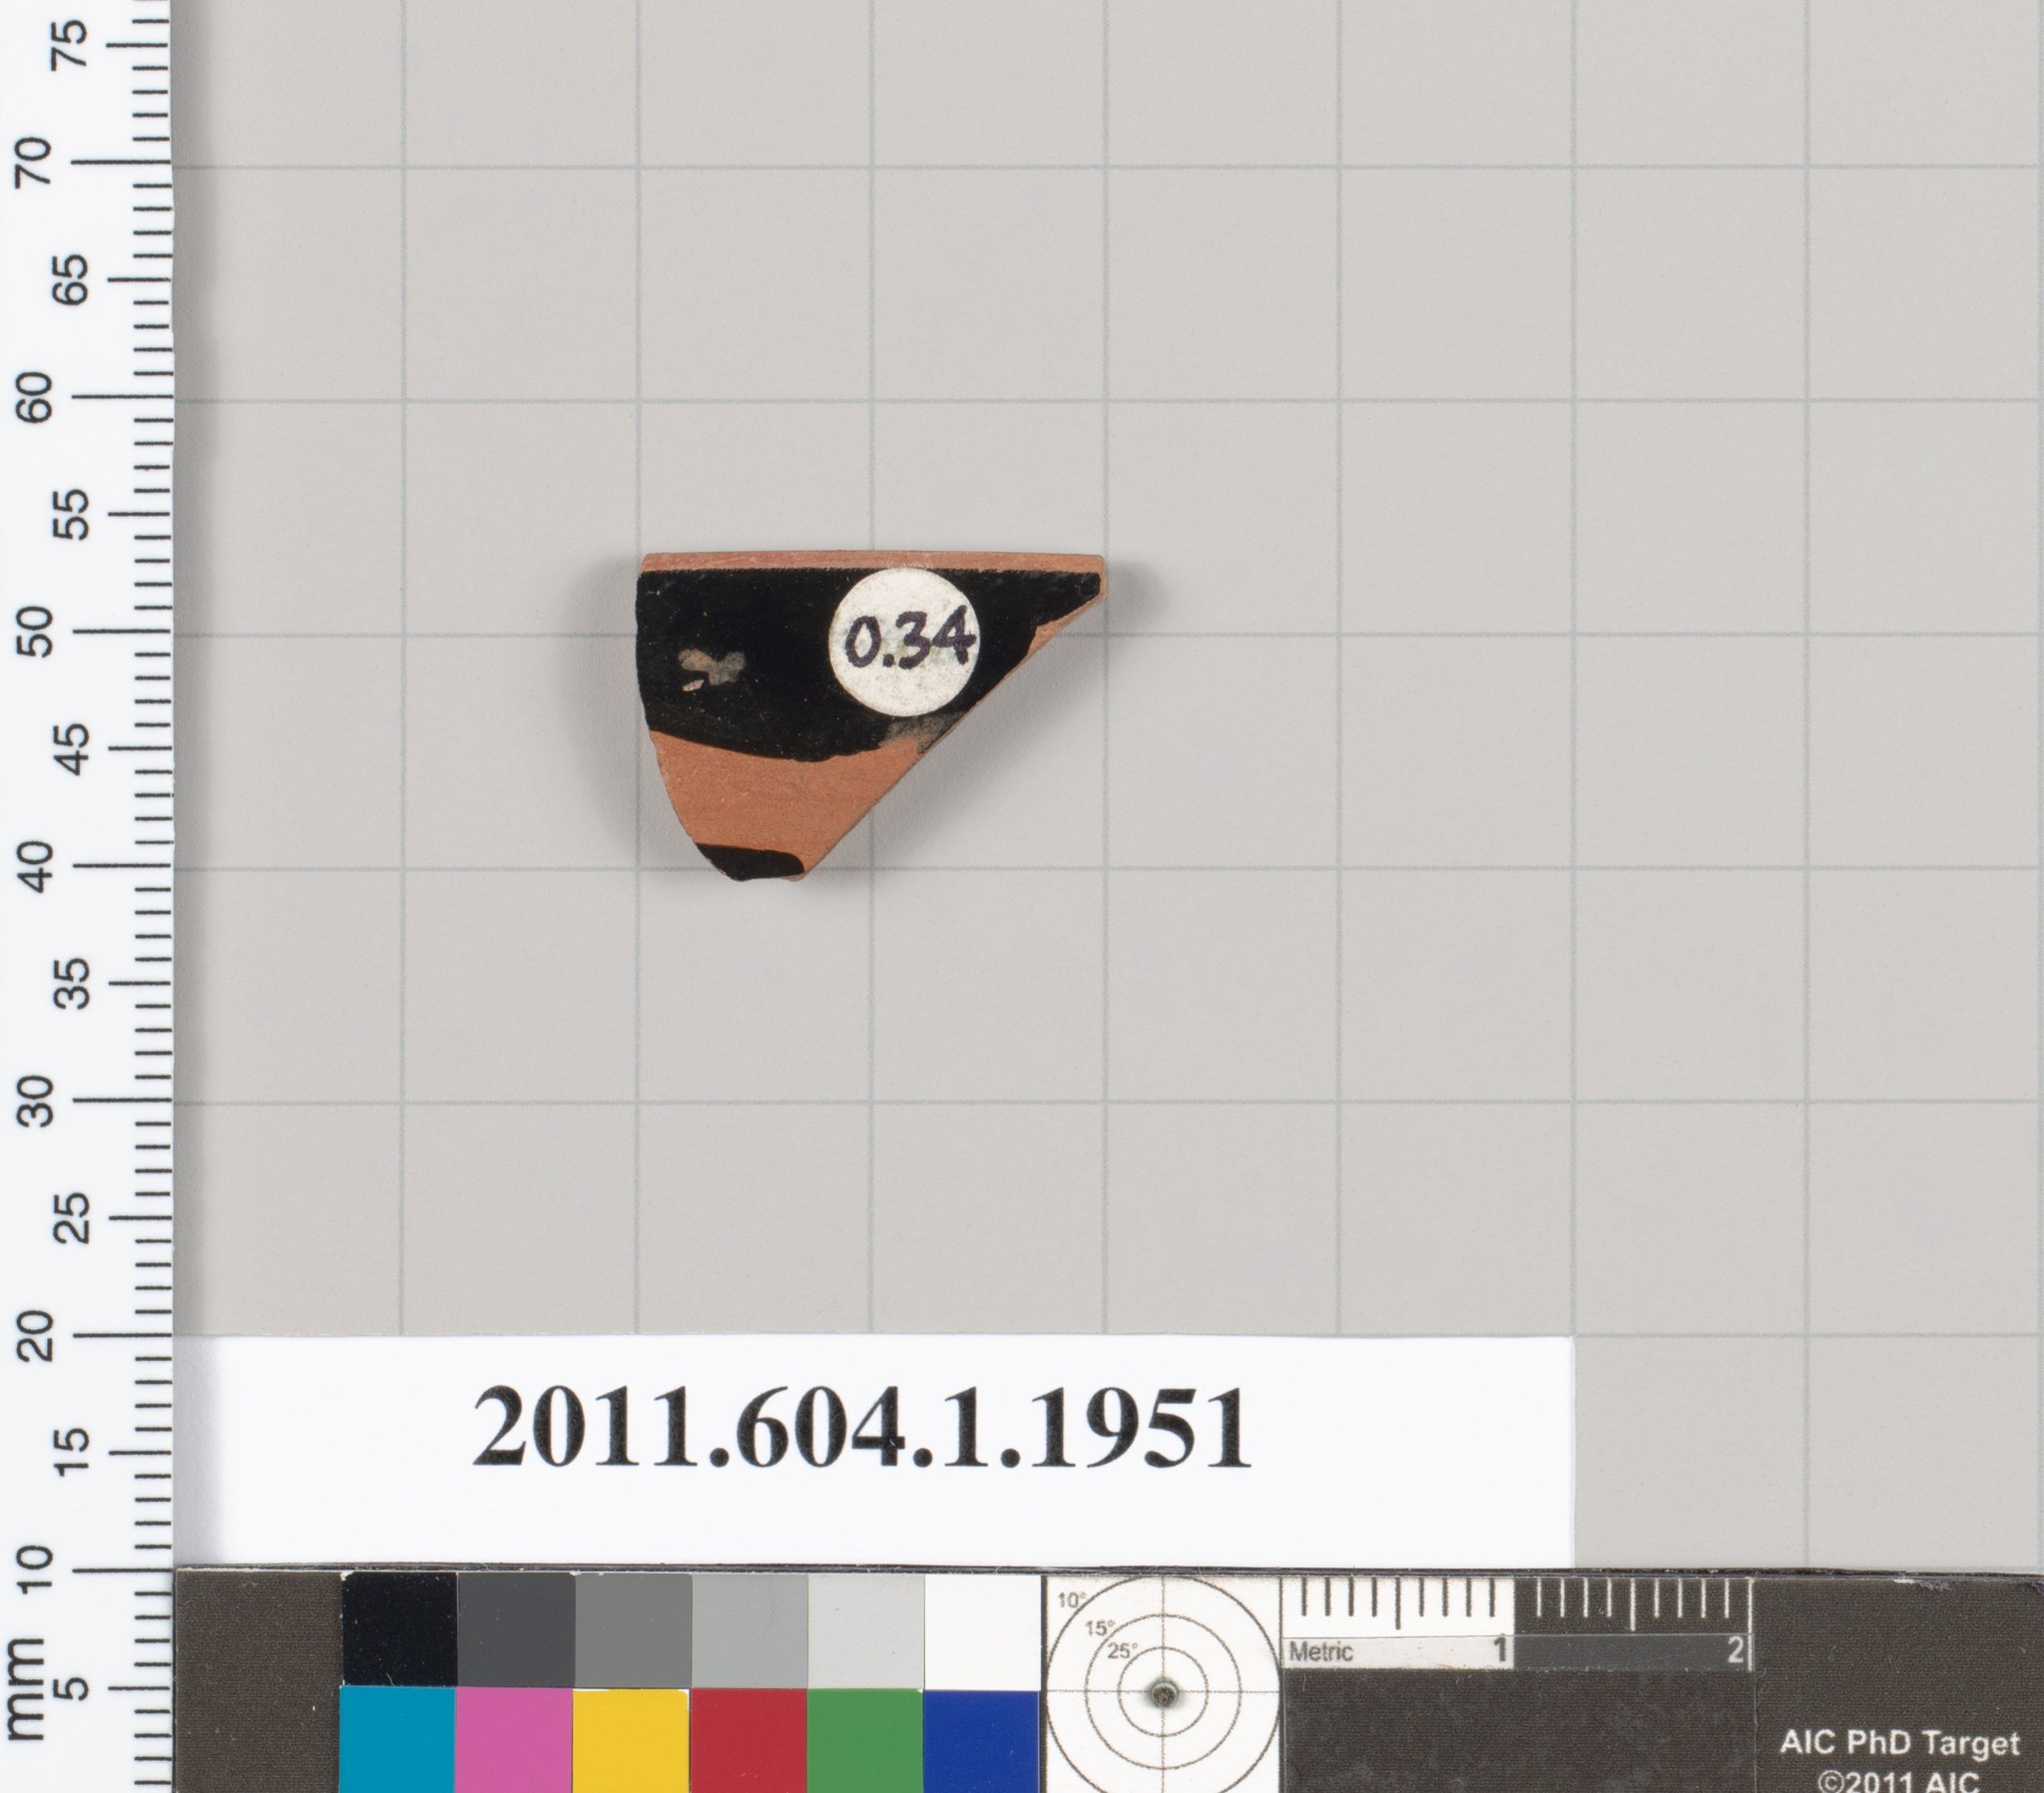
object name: kylix fragment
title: Terracotta rim fragment of a kylix (drinking cup)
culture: greek, attic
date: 475-451 BCE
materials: terracotta